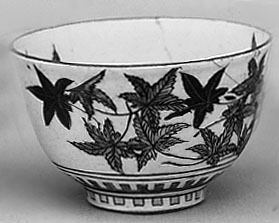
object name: cup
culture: japanese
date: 1800-1850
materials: glaze, gold, pottery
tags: leaves